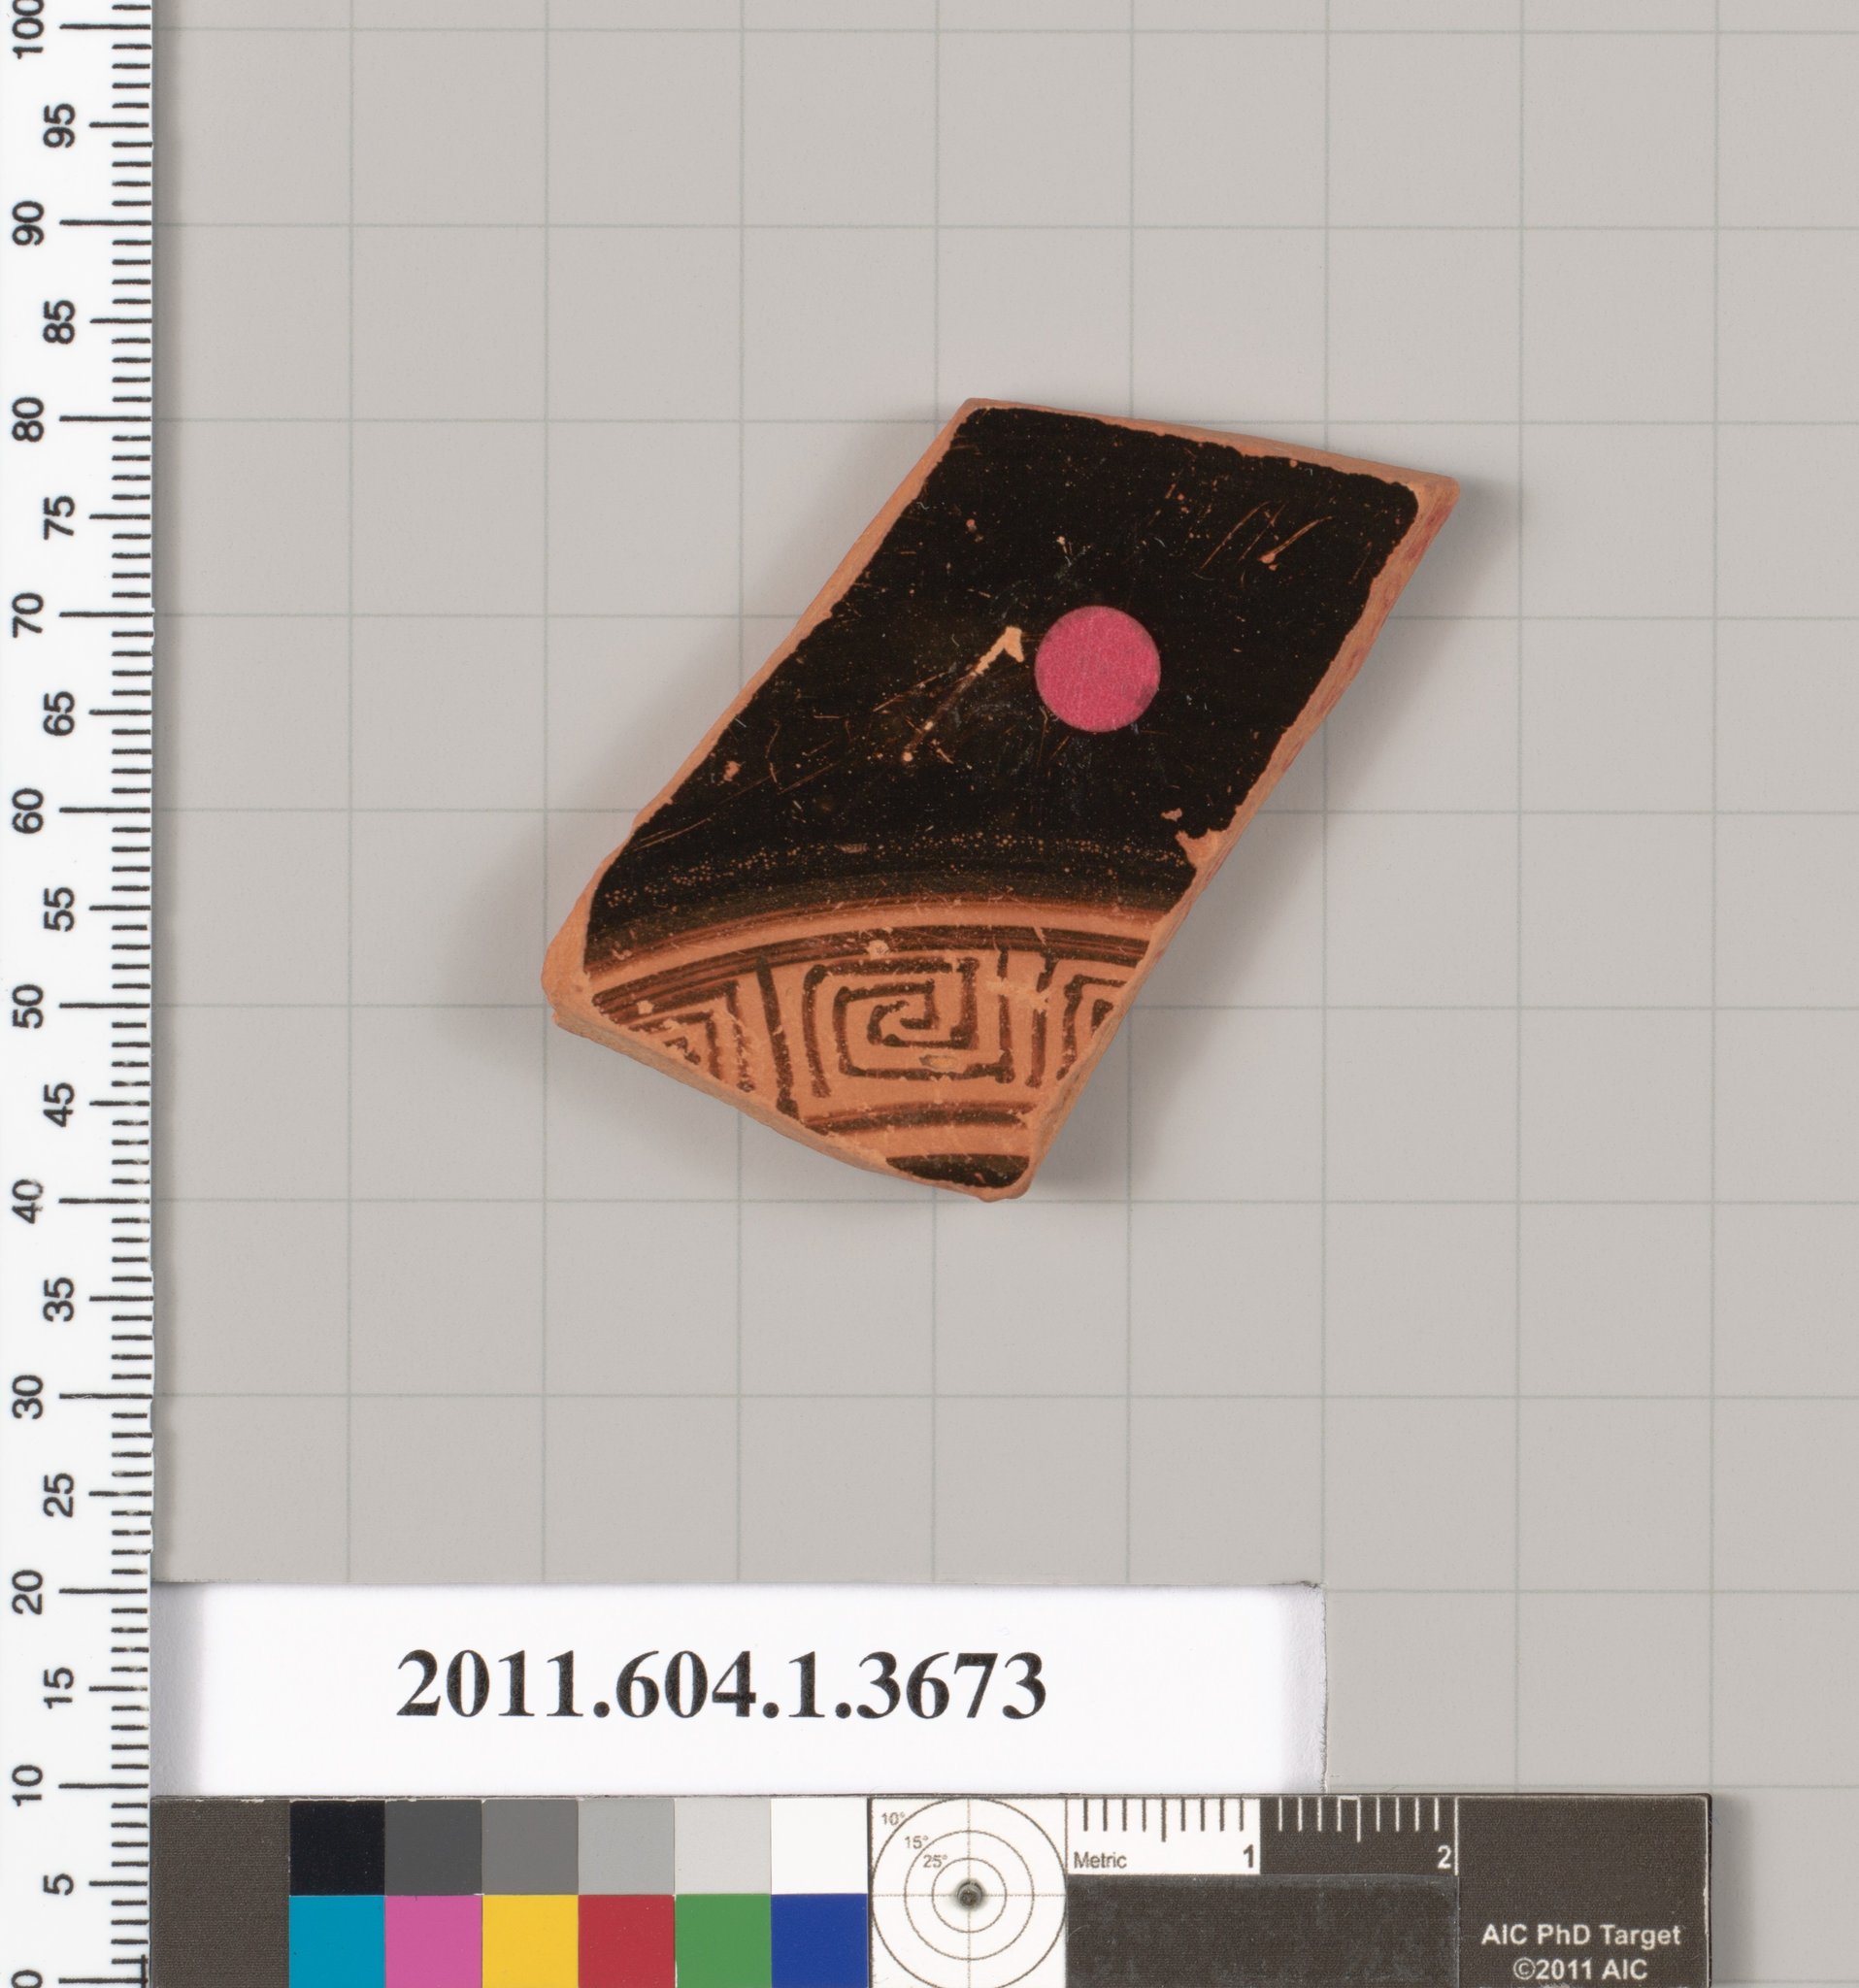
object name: kylix fragment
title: Terracotta fragment of a kylix (drinking cup)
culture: greek, attic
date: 475-451 BCE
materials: terracotta